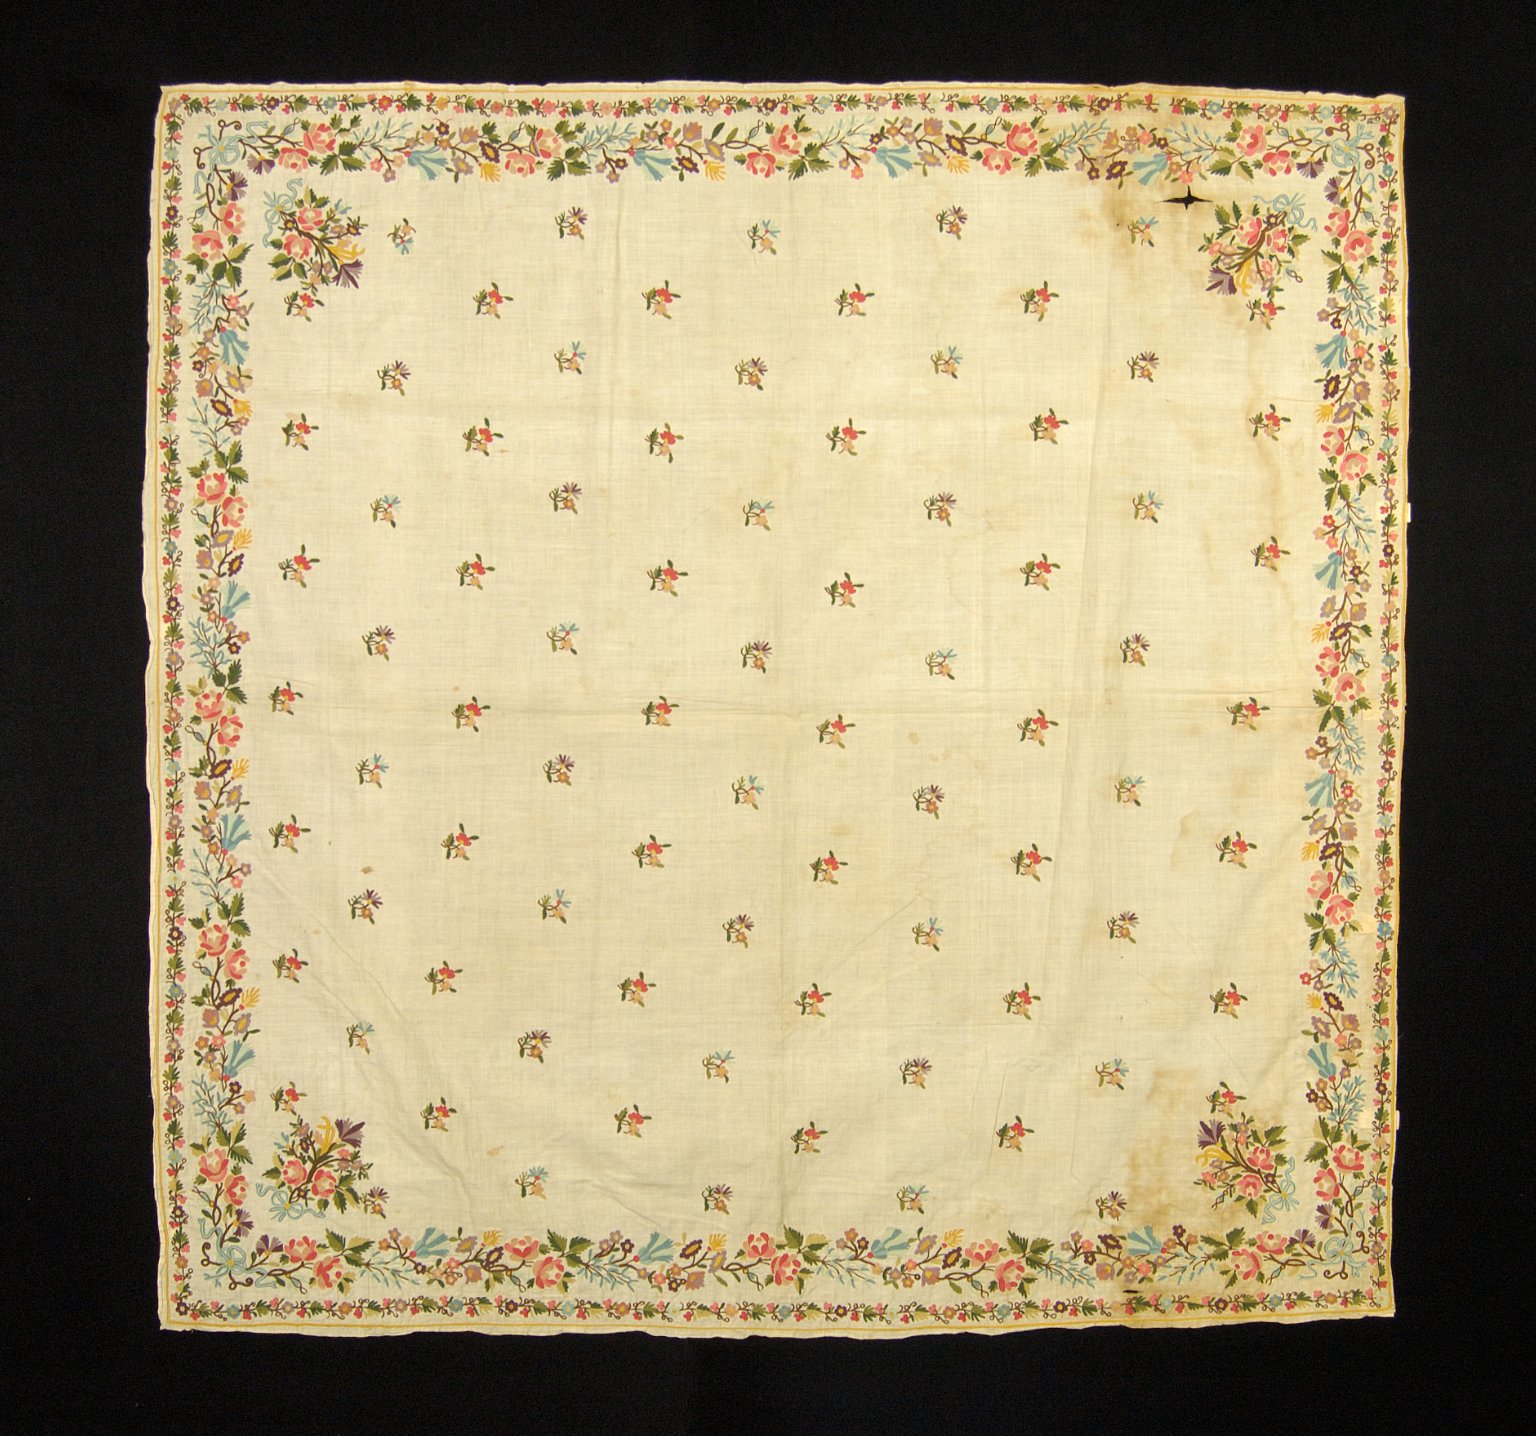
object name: kerchief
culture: russian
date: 1740-1770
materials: cotton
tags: flowers